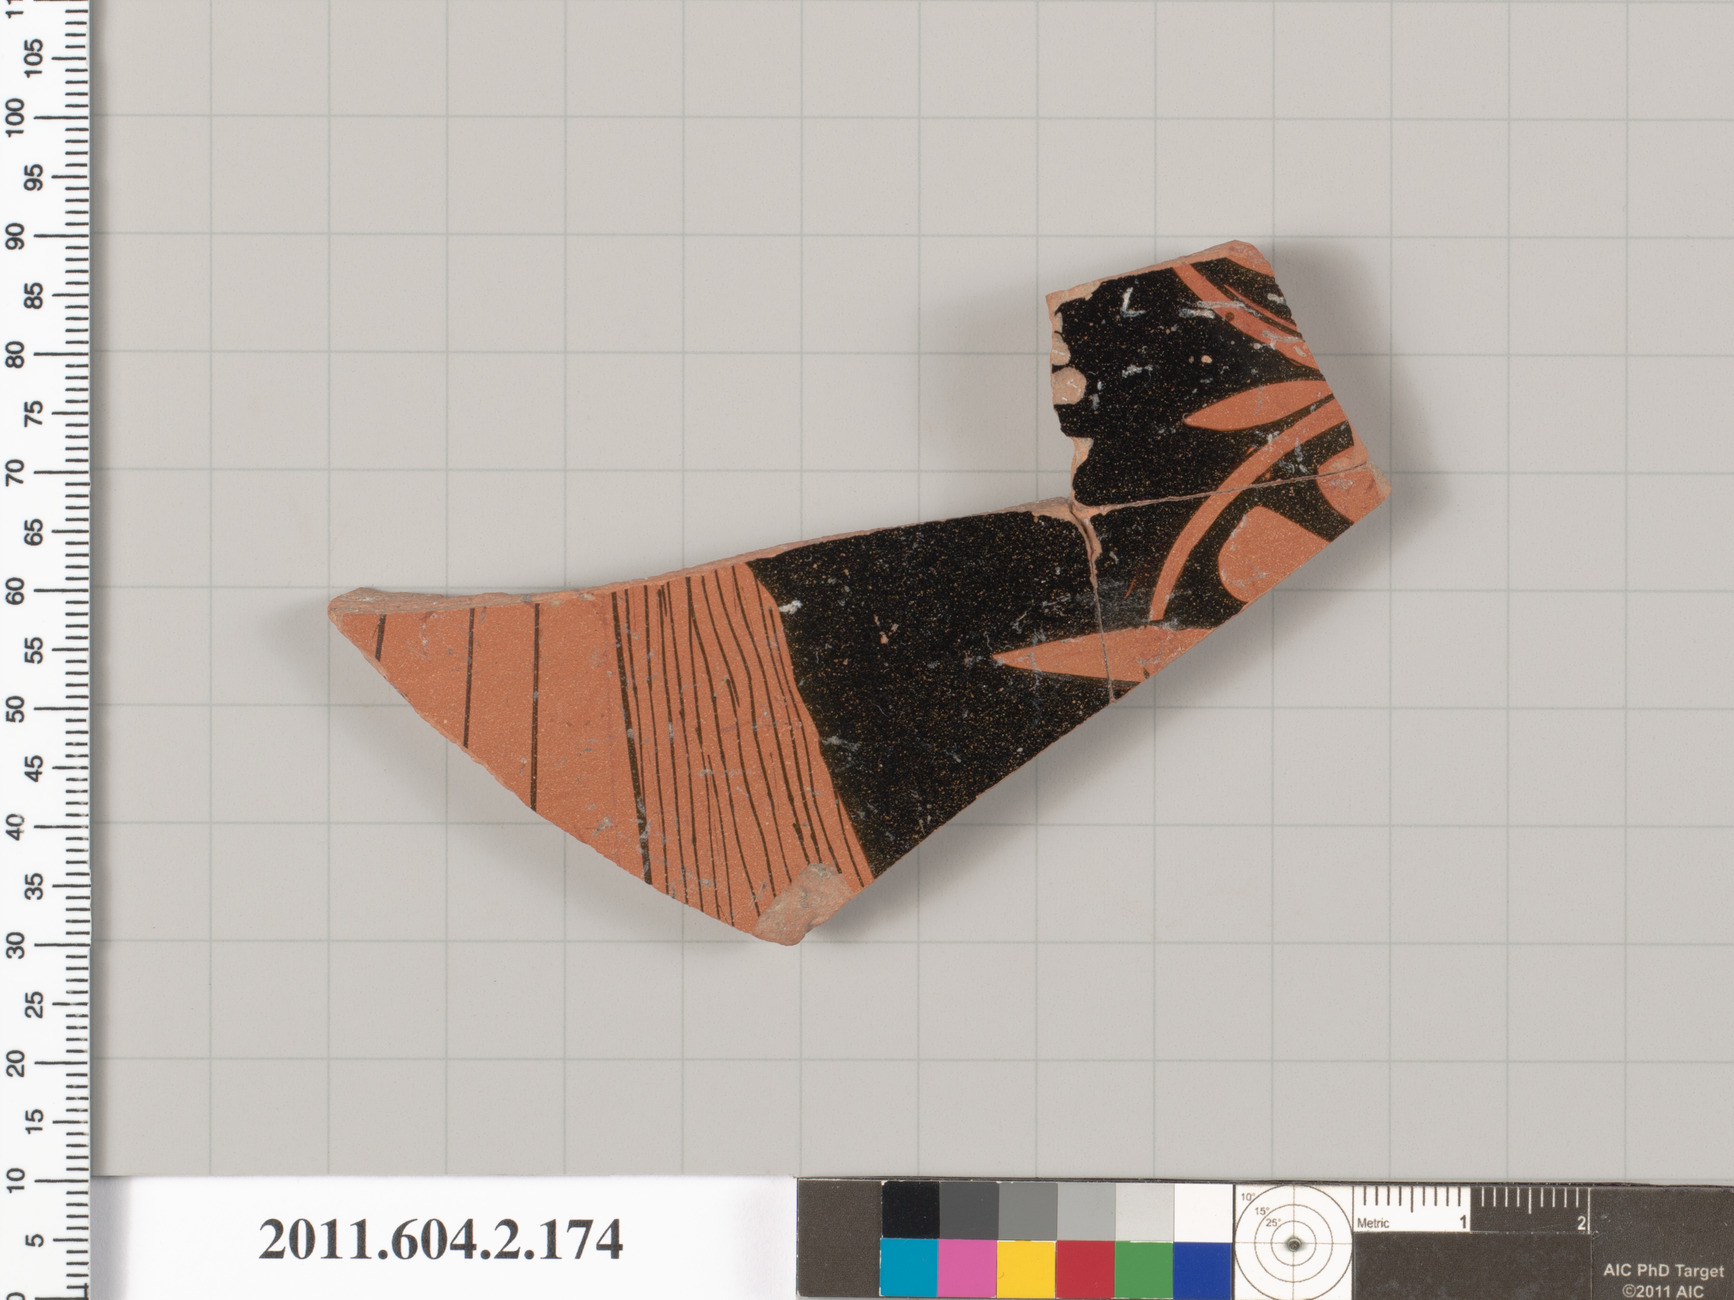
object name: stamnos fragment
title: Terracotta fragment of a stamnos (jar)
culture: greek, attic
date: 470-460 BCE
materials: terracotta